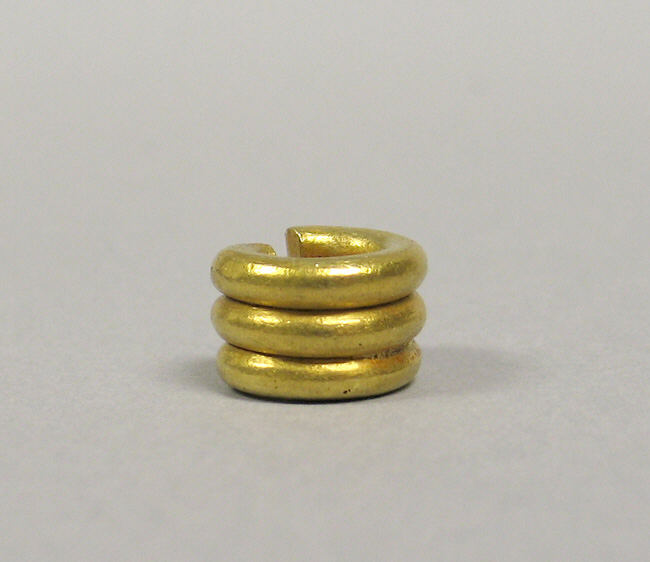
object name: pair of ear ornament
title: Pair Ear Ornaments, Three Plain Hoops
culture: indonesian, central java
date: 701-1200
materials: gold